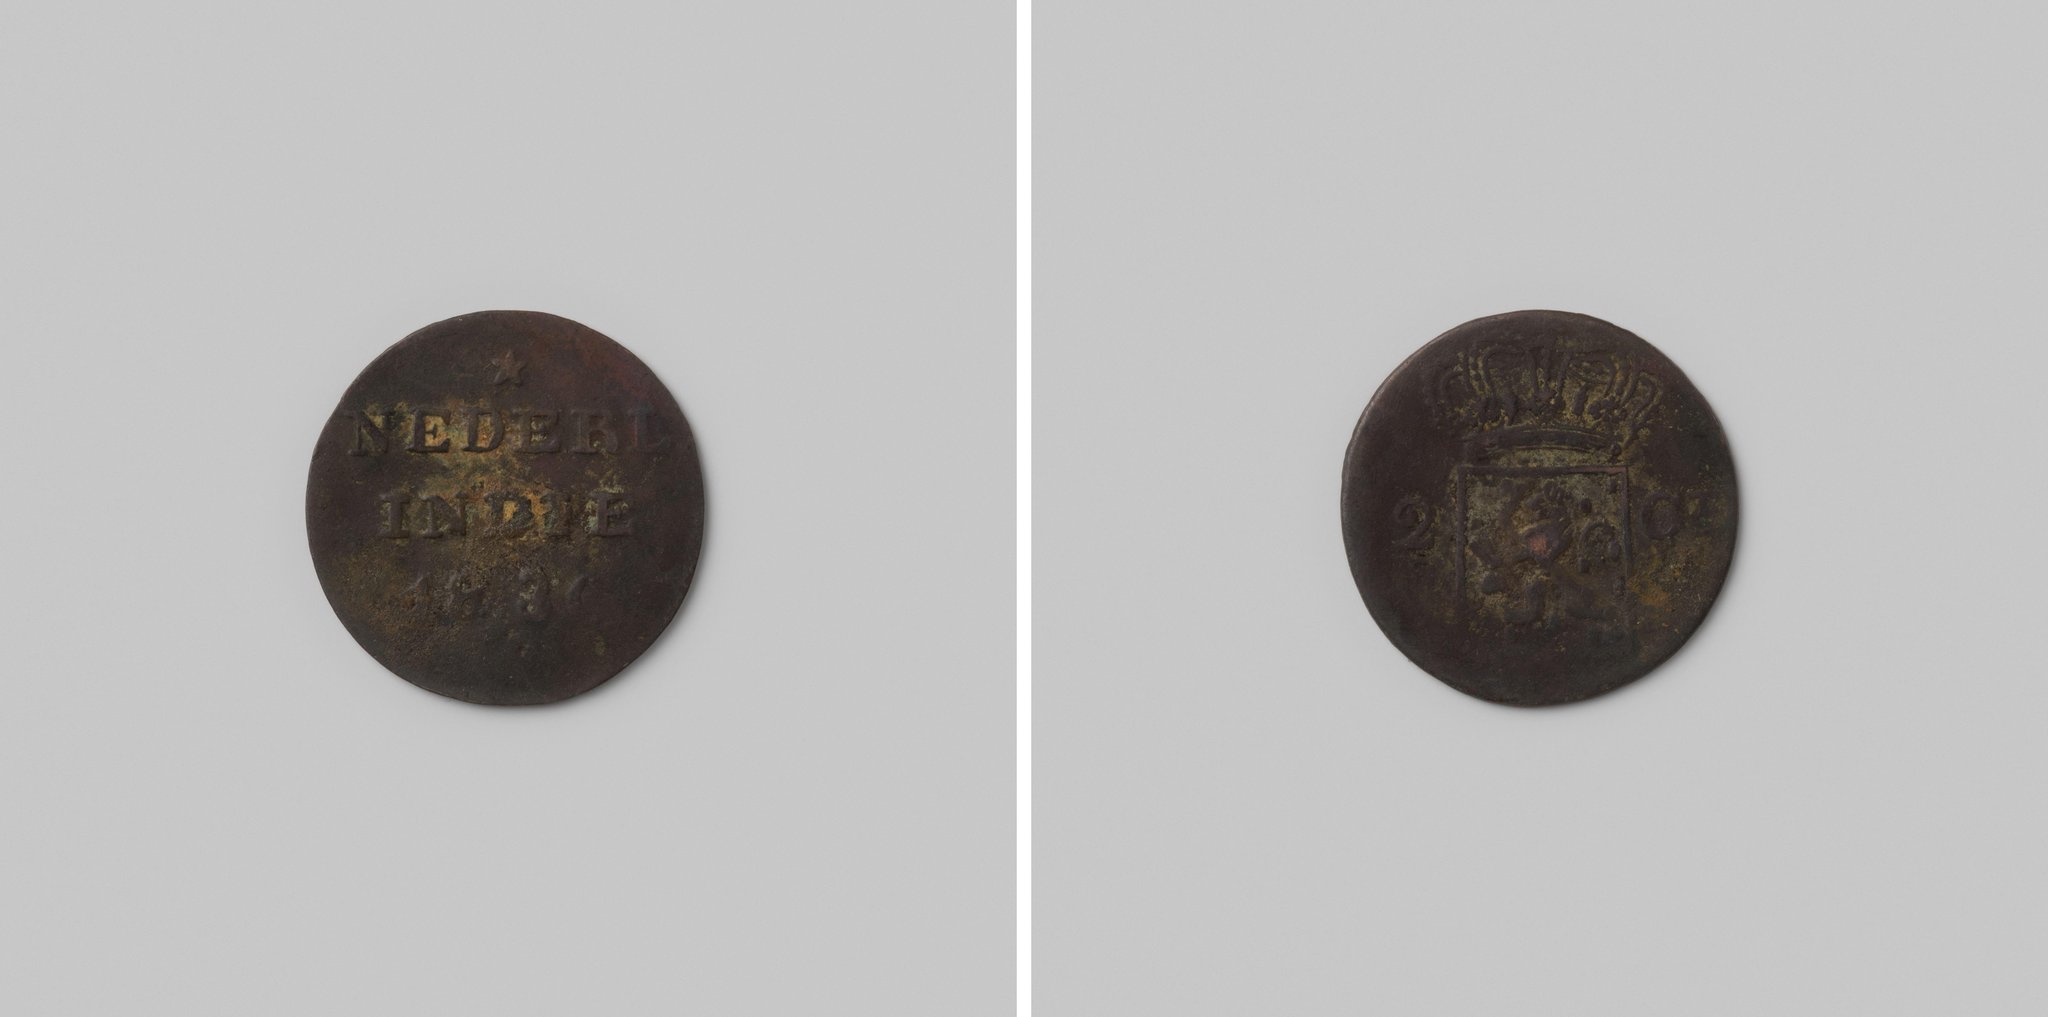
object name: coin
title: Munt van twee cent van de VOC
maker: Anonymous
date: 1836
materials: copper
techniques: striking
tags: dutch east indies, the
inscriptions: inscription: ‘2 Ct’, inscription: ‘Jacques Schulman / Numismaat / Keizersgracht 448 / Amsterdam-C.’, inscription: ‘* NEDERL / INDIE / 1836’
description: Koperen VOC-muntje van 2 cent uit Nederlands-Indië. Voorzijde: opschrift, jaartal slecht leesbaar, waarschijnlijk 1836. Keerzijde: wapen met leeuw erin, links ervan een 2 en rechts ervan Ct. Het muntje zit in een vierkant envelopje met opschrift.